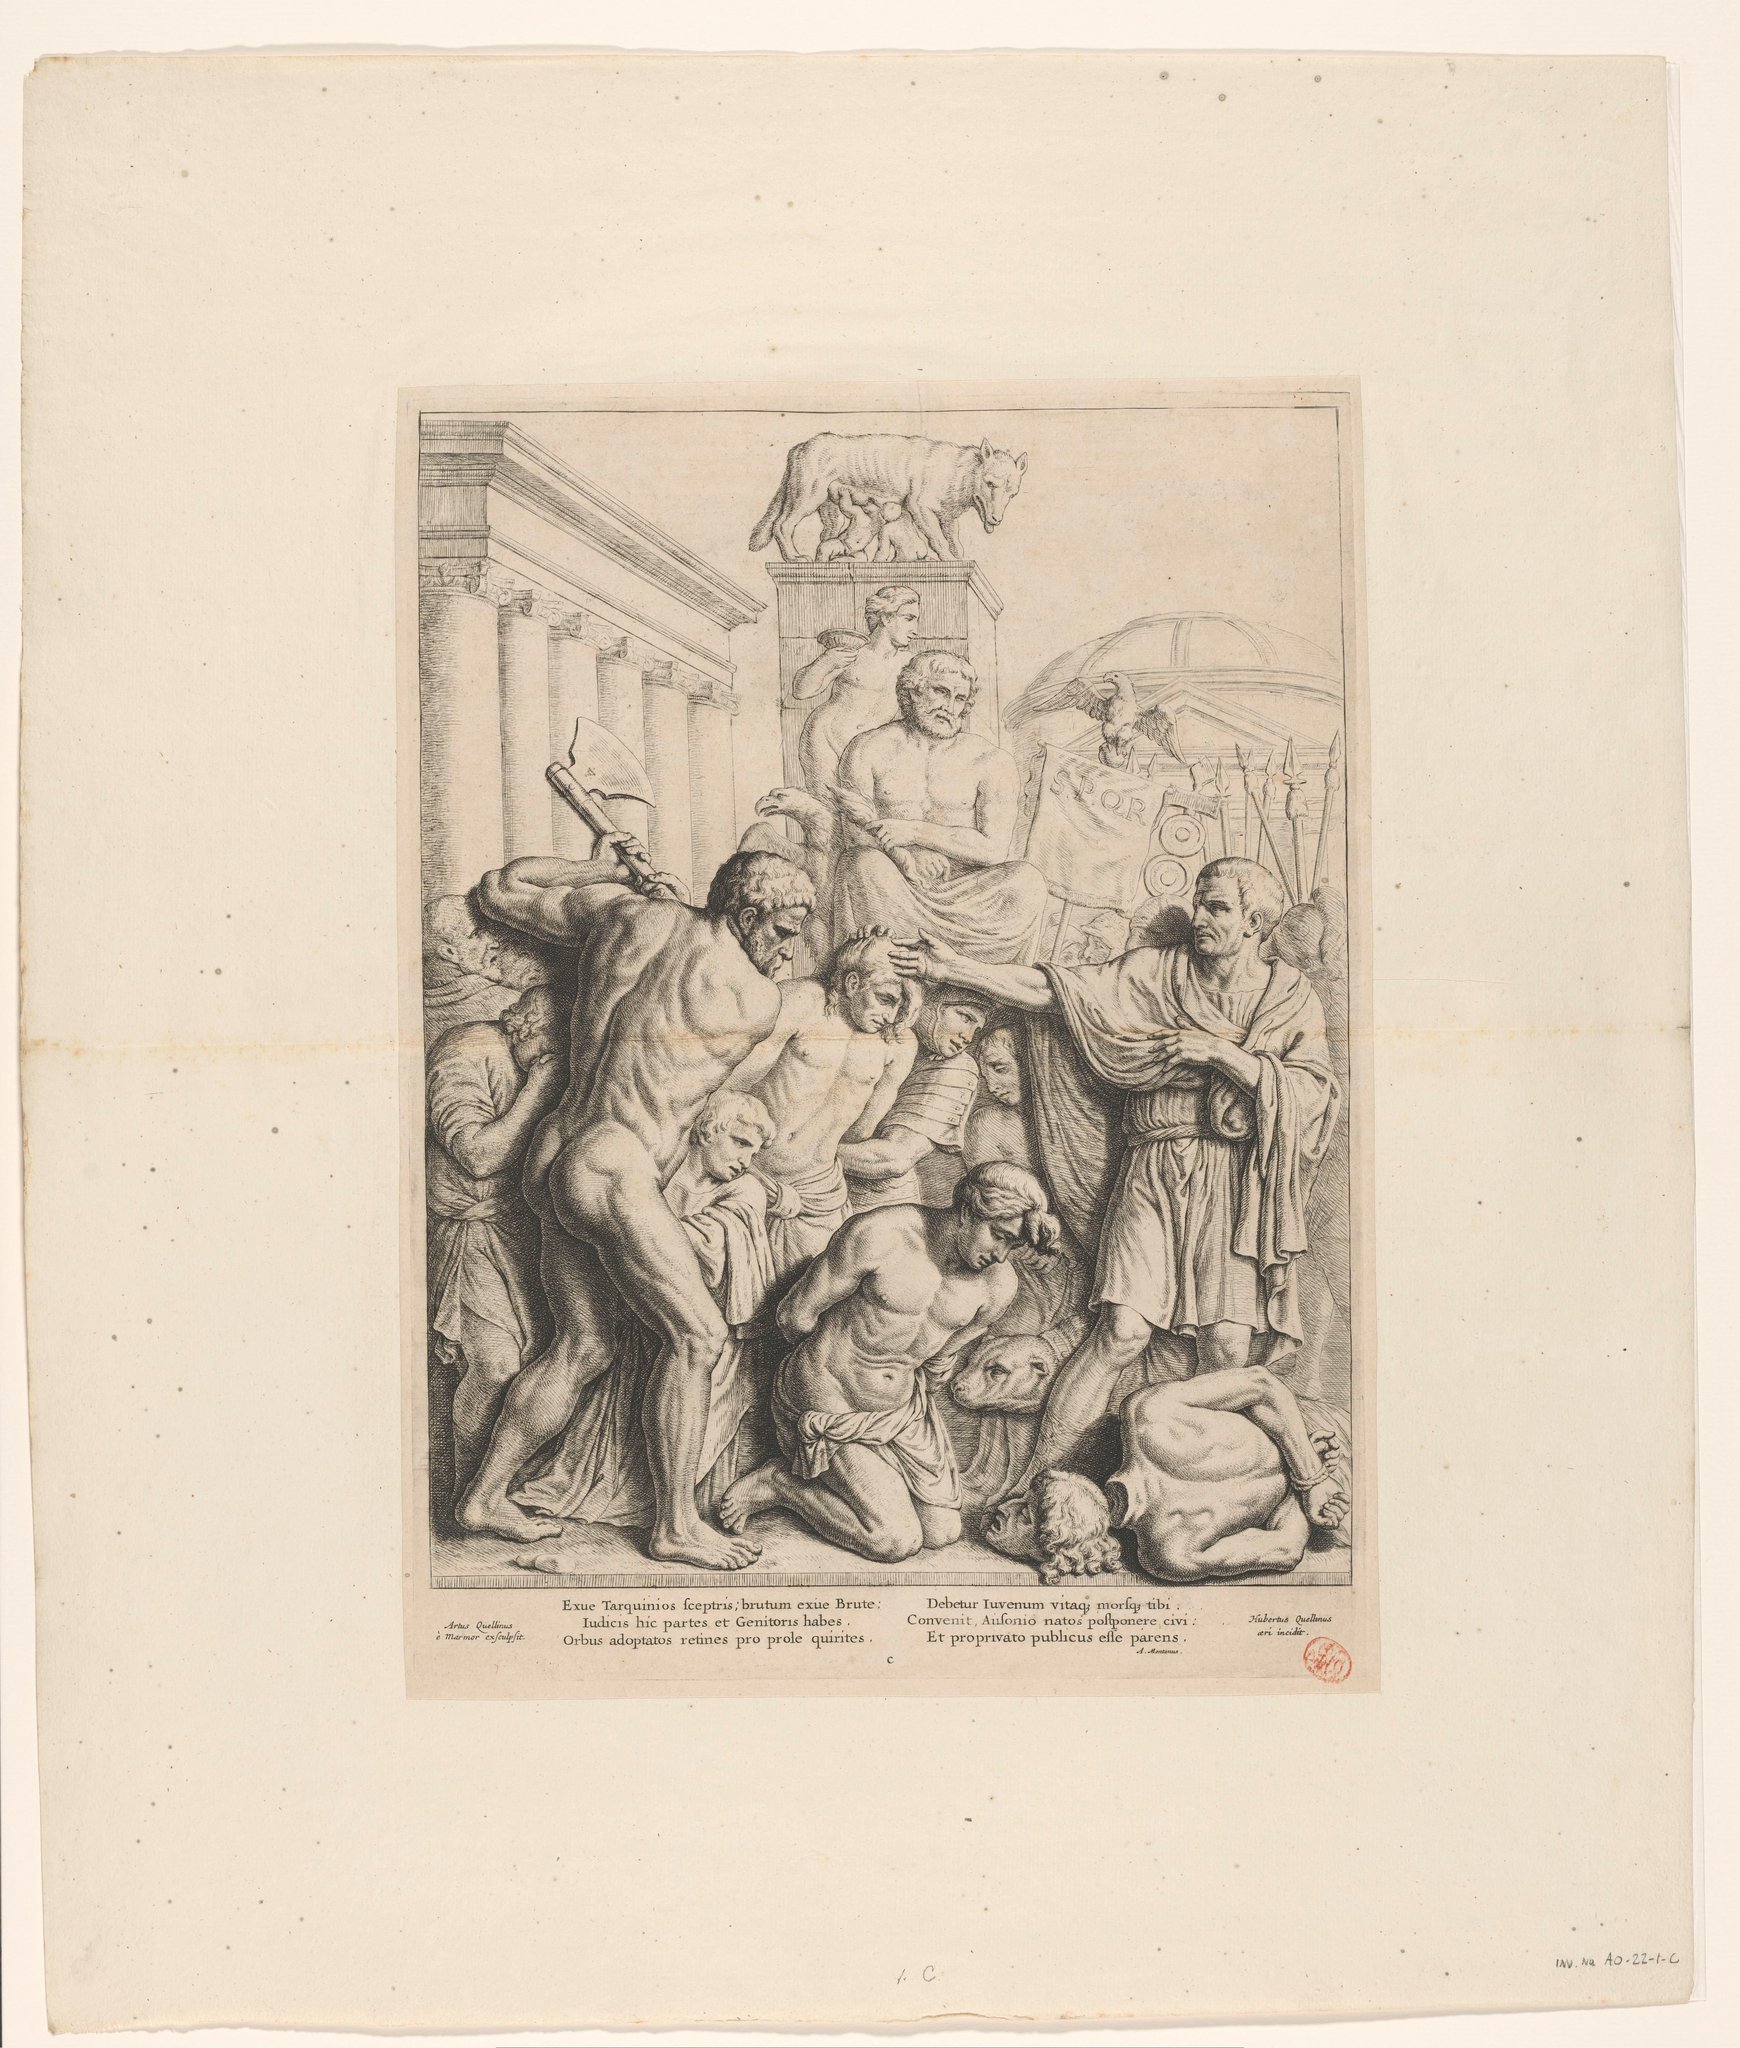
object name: book illustration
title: Reliëf met het oordeel van Lucius Junius Brutus in de Vierschaar van het Stadhuis op de Dam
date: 1655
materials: paper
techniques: engraving, etching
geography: amsterdam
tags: l. junius brutus has his two sons beheaded because they joined a conspiracy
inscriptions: collector's mark: Lugt 195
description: Prent gebruikt in: Prima pars. Praecipuarum effigierum ac ornamentorum, amplissimae Curiae Amstelrodamensis (…) / Het eerste deel. Van de voornaemste Statuen ende Ciraten, vant konstijck Stadhuys van Amstelredam, tmeeste in marmer gemaeckt, door Artus Quellinus, Beelthouwer der voorseyde Stadt / La Premier Partie. De plusieurs Figures et ornements, de la Maison de Ville d'Amsterdam (…). Amsterdam: Artus Quellinus (I), 1655. Zie RP-P-AO-22-1-1 voor bijhorende titelpagina. Zie RP-P-AO-22-1-2 voor bijhorend register. Zie RP-P-AO-22-1A, RP-P-AO-22-1B, RP-P-AO-22-1D-1, RP-P-AO-22-1D-2, RP-P-AO-22-1E, RP-P-AO-22-1F, RP-P-AO-22-1G, RP-P-AO-22-1H, RP-P-AO-22-1I, RP-P-AO-22-1K-1, RP-P-AO-22-1K-2, RP-P-AO-22-1K-3, RP-P-AO-22-1K-4, RP-P-AO-22-1K-5, RP-P-AO-22-1L-1, RP-P-AO-22-1L-2, RP-P-AO-22-1M-1, RP-P-AO-22-1M-2, RP-P-AO-22-1N-1, RP-P-AO-22-1N-2, RP-P-AO-22-1N-3, RP-P-AO-22-1N-4, RP-P-AO-22-1N-5, RP-P-AO-22-1O-1, RP-P-AO-22-1O-2, RP-P-AO-22-1O-3, RP-P-AO-22-1O-4, RP-P-AO-22-1P-1, RP-P-AO-22-1P-2, RP-P-AO-22-1P-3, RP-P-AO-22-1P-4, RP-P-AO-22-1Q-1, RP-P-AO-22-1Q-2, RP-P-AO-22-1Q-3, RP-P-AO-22-1Q-4, RP-P-AO-22-1R-1, RP-P-AO-22-1R-2, RP-P-AO-22-1R-3, RP-P-AO-22-1R-4, RP-P-AO-22-1R-5, RP-P-AO-22-1S-1, RP-P-AO-22-1S-2, RP-P-AO-22-1S-3, RP-P-AO-22-1S-4, RP-P-AO-22-1S-5, RP-P-AO-22-1T-1 en RP-P-AO-22-1T-2 voor andere prenten uit deze publicatie. Zelfde staat van prent ook gebruikt in: Prima pars. Praecipuarum effigierum ac ornamentorum, amplissimae Curiae Amstelrodamensis (…) / Het eerste deel. Van de voornaemste Statuen ende Ciraten, vant konstijck Stadhuys van Amstelredam, tmeeste in marmer gemaeckt, door Artus Quellinus, Beelthouwer der voorseyde Stadt / La Premier Partie. De plusieurs Figures et ornements, de la Maison de Ville d'Amsterdam (…). Amsterdam: Frederik de Wit, 1665. Latere staat van prent ook gebruikt in: Architecture peinture et sculpture de la Maison de Ville d'Amsterdam, representee en CIX. figures en taille-douce (…). Amsterdam: David Mortier, 1719. En in: Architecture peinture et sculpture de la Maison de Ville d'Amsterdam, representee en CIX. figures en taille-douce (…). Amsterdam: Gerard Valck, 1719. En in: Bouw schilder en beeldhouwkonst, van het Stadhuis te Amsteldam, vertoont in CIX figuuren (…). Amsterdam: Covens & Mortier & Covens Jr., s.a. (1774-1783). Zie BK-AM-51-21 voor model van beeld.